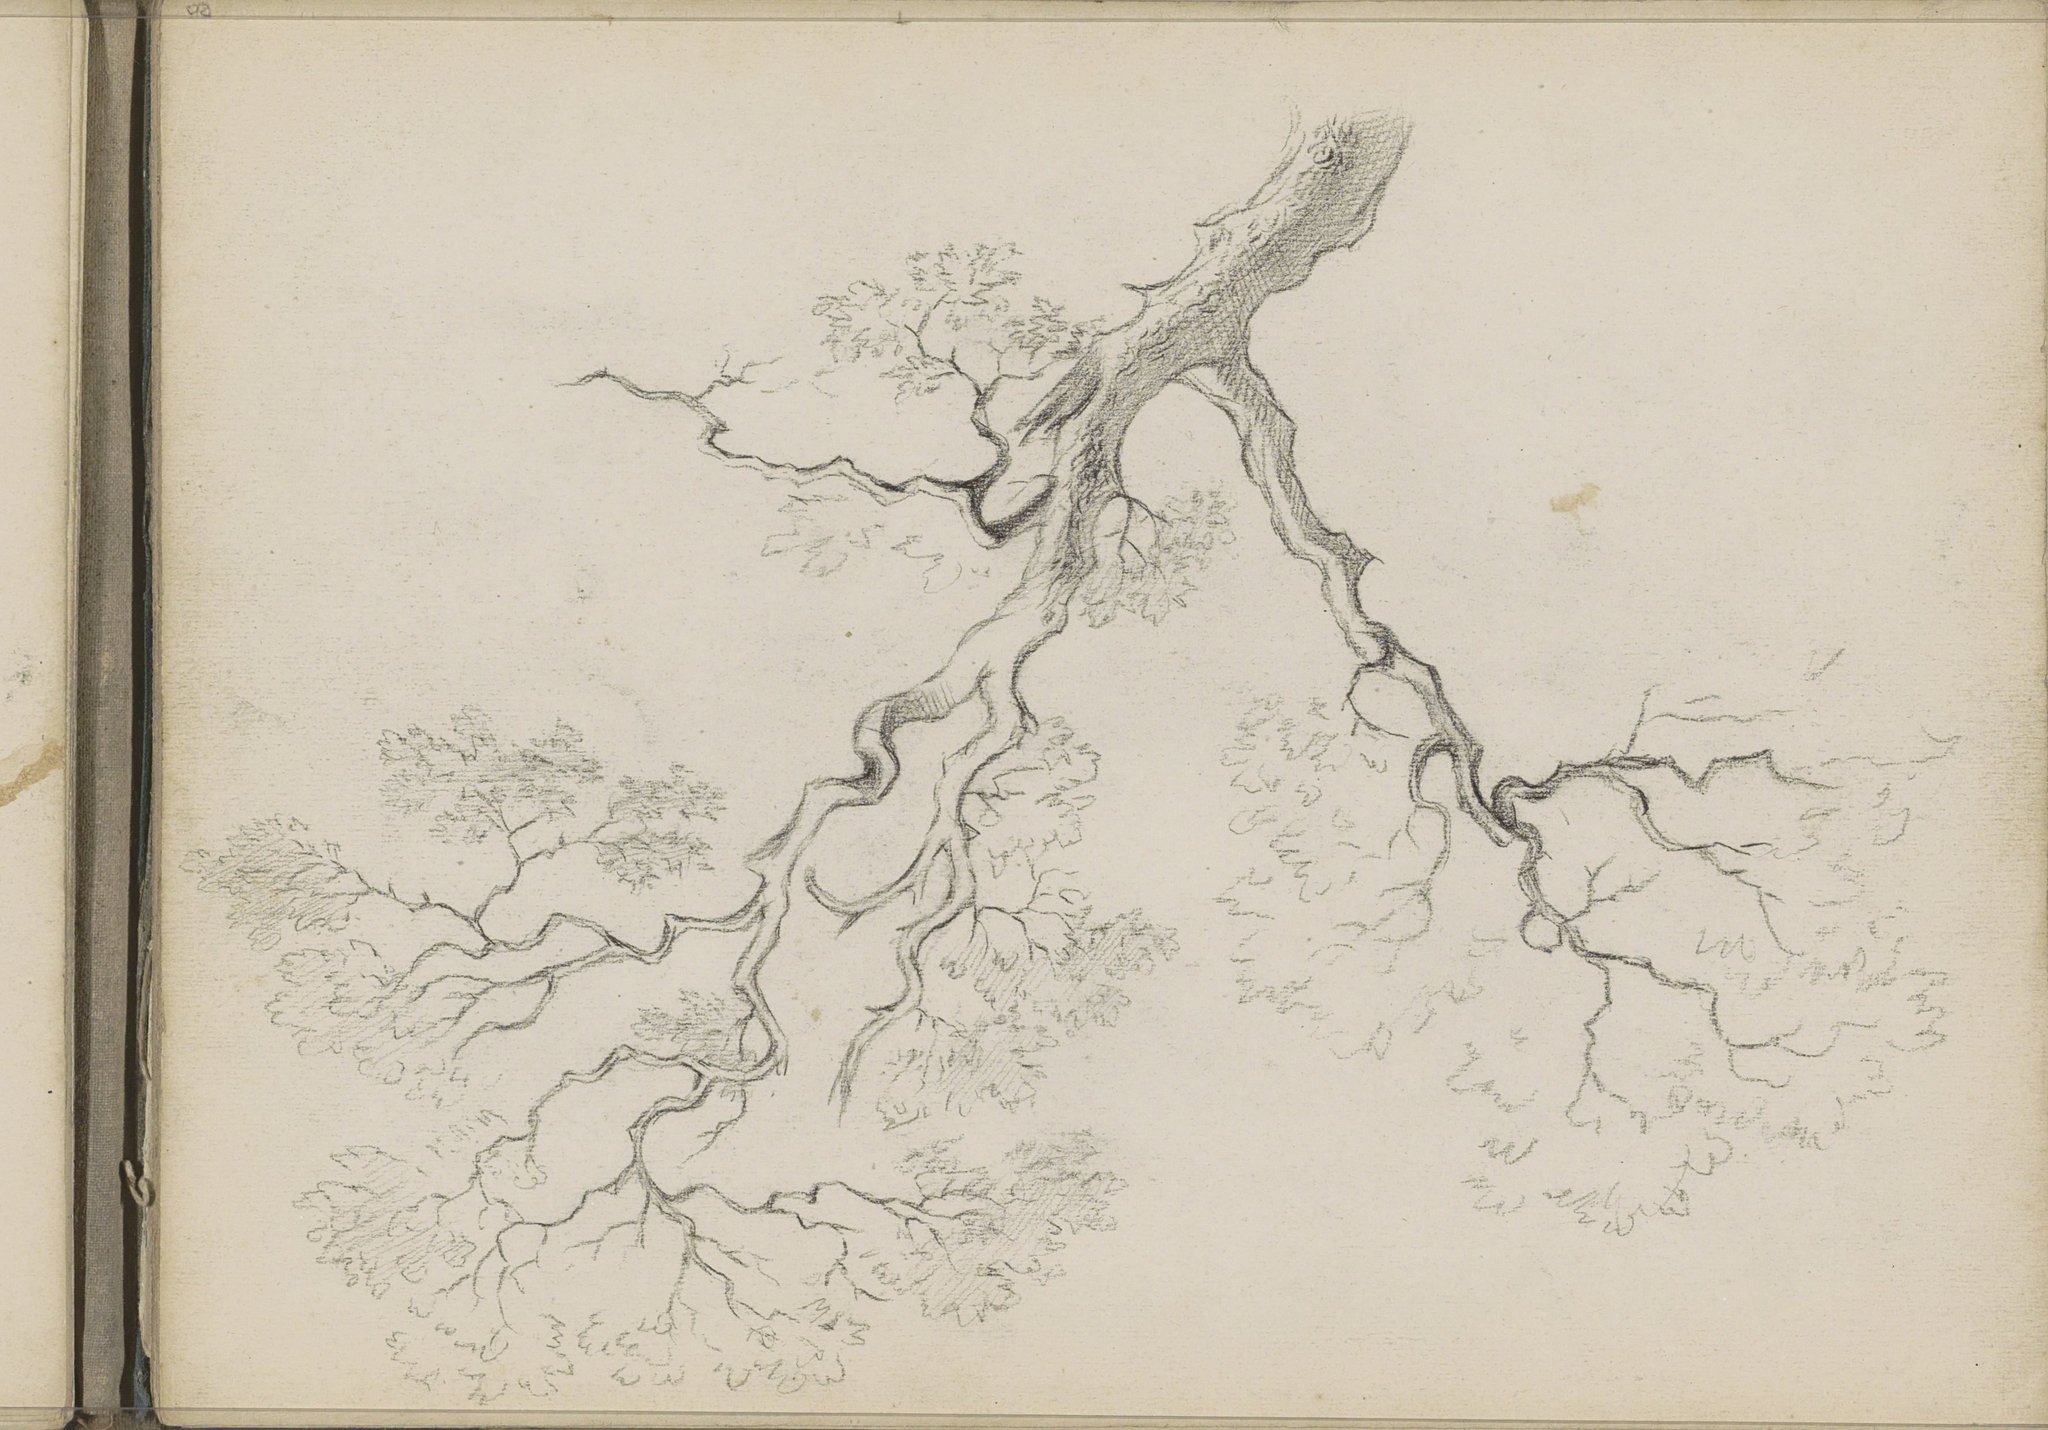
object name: sketchbook leaf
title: Boom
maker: willem cornelis rip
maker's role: draughtsman, painter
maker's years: 1856-1922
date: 1874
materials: chalk, paper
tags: trees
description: Blad 20 recto uit een schetsboek met 27 losse bladen.